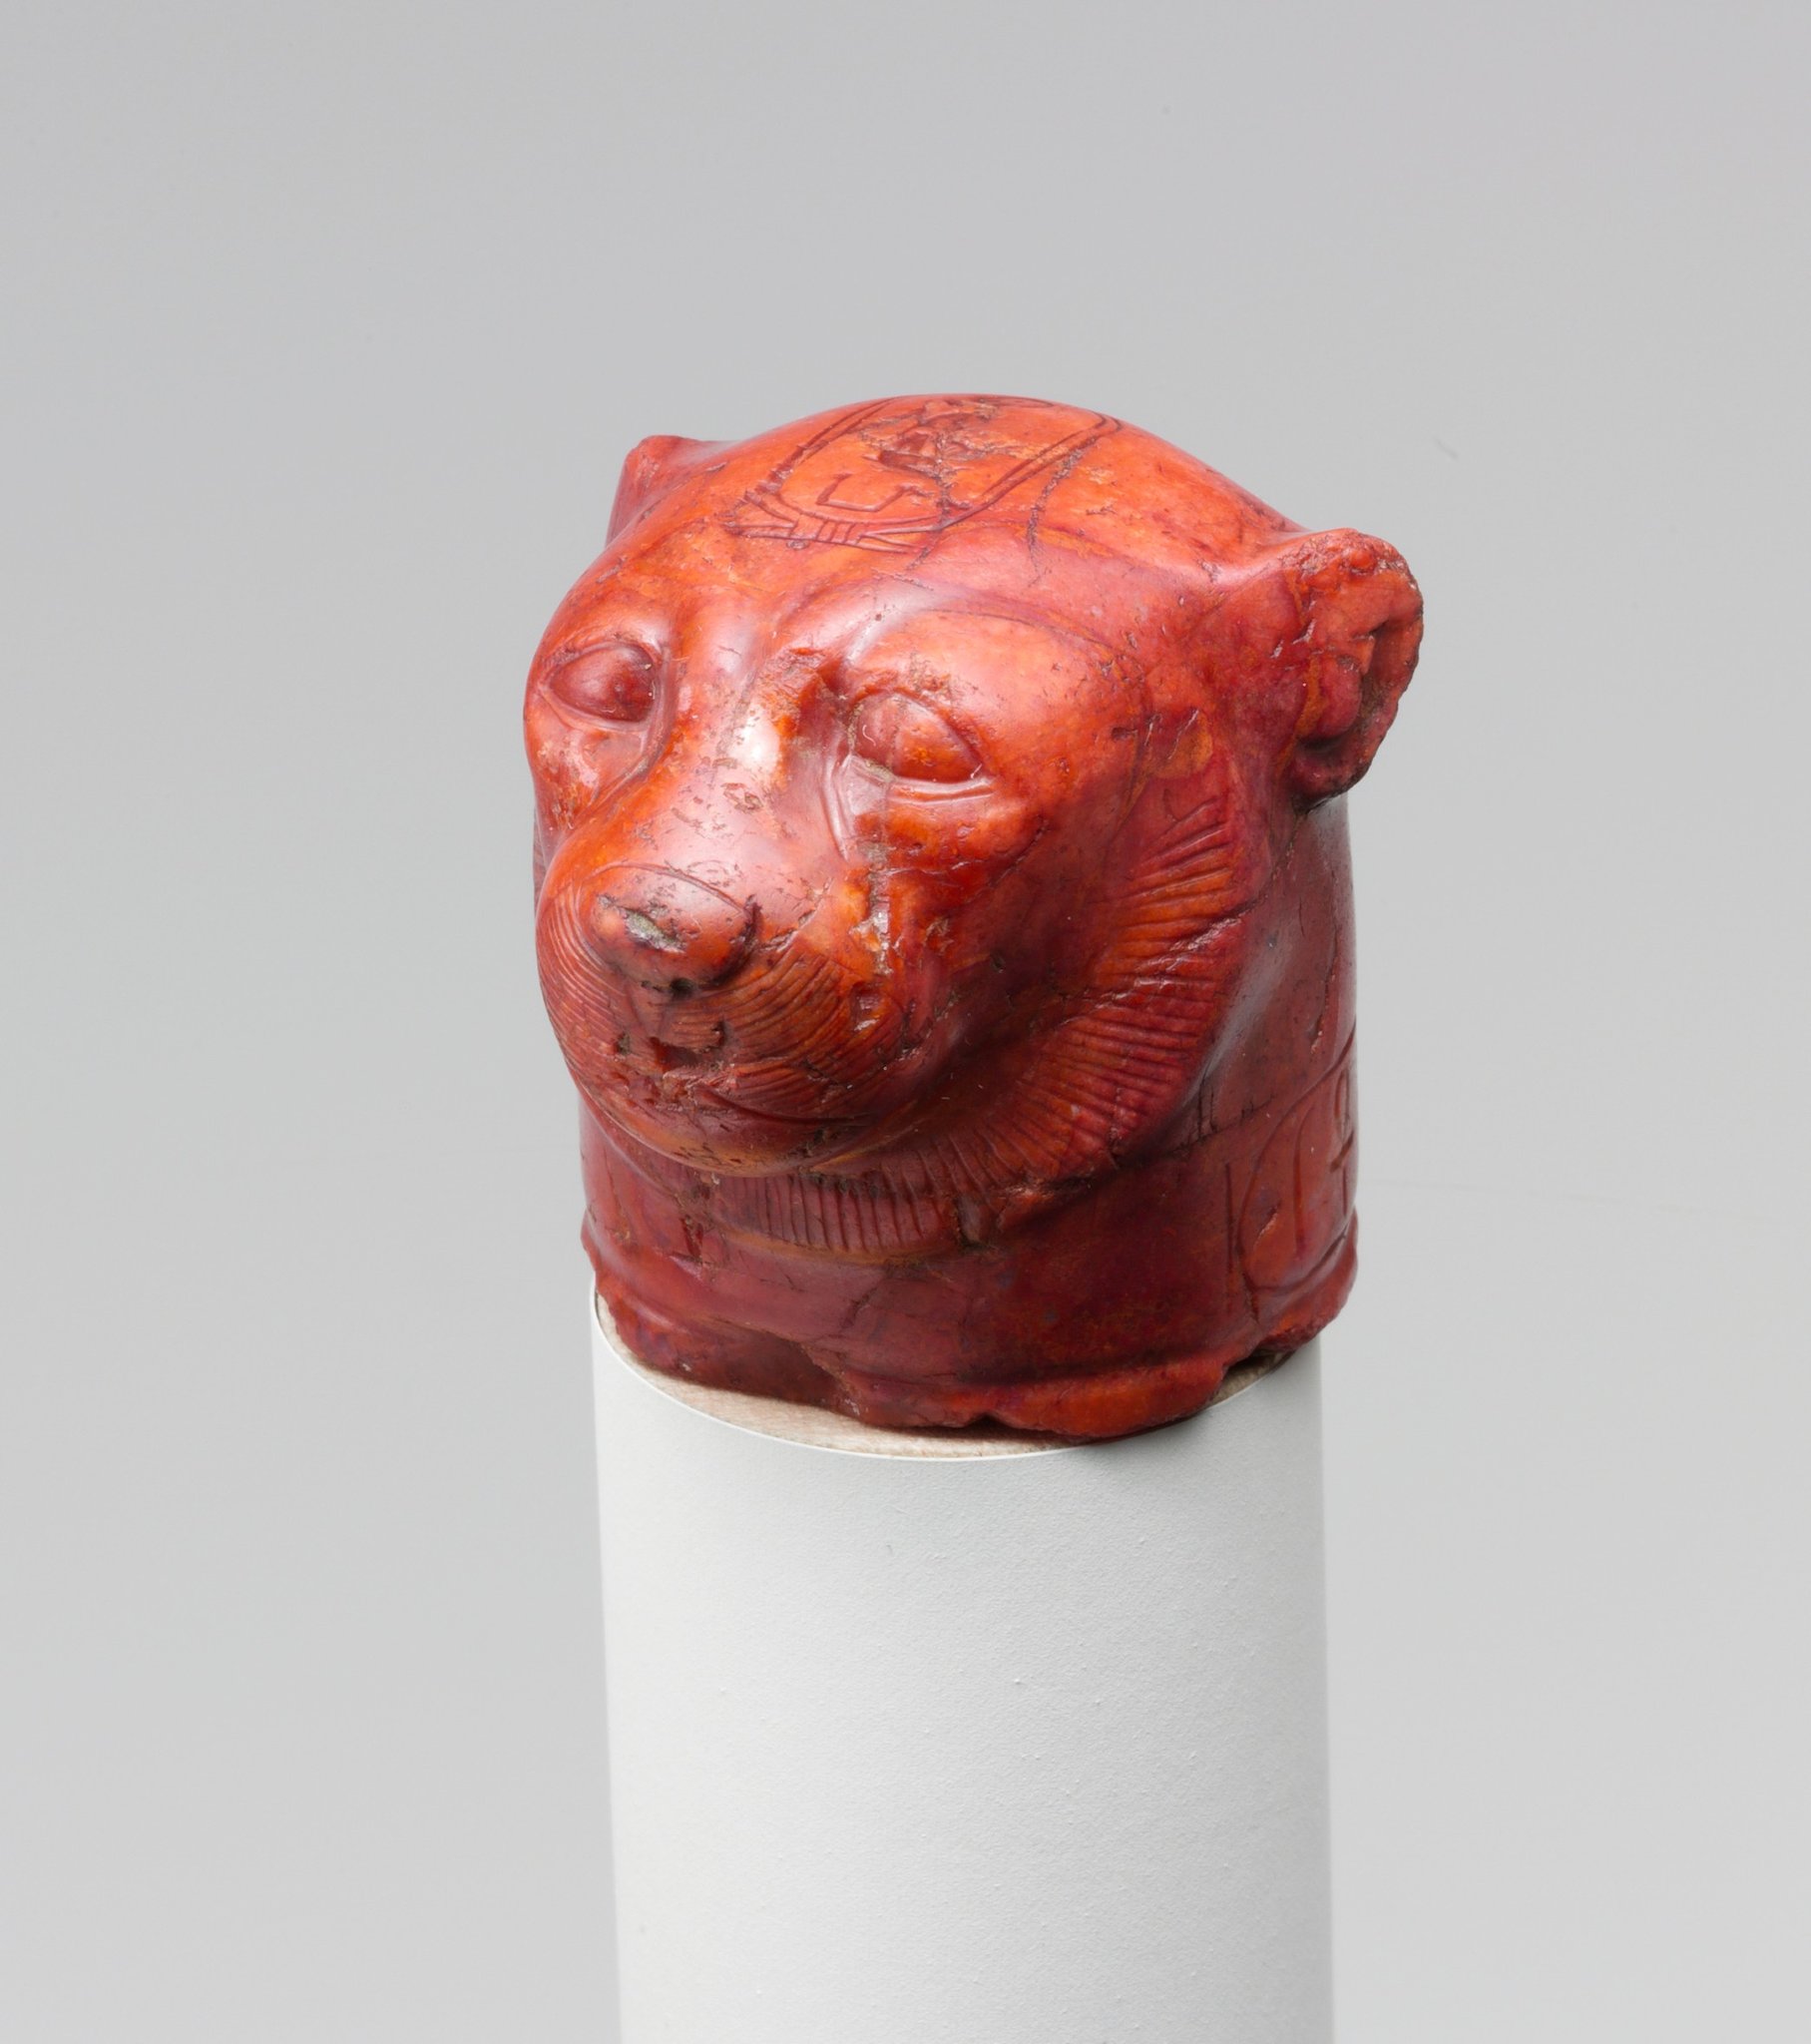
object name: game piece, leopard head with name of hatshepsut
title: Head of a Leopard with the Name of Hatshepsut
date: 1479-1458 BCE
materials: jasper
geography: egypt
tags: leopards